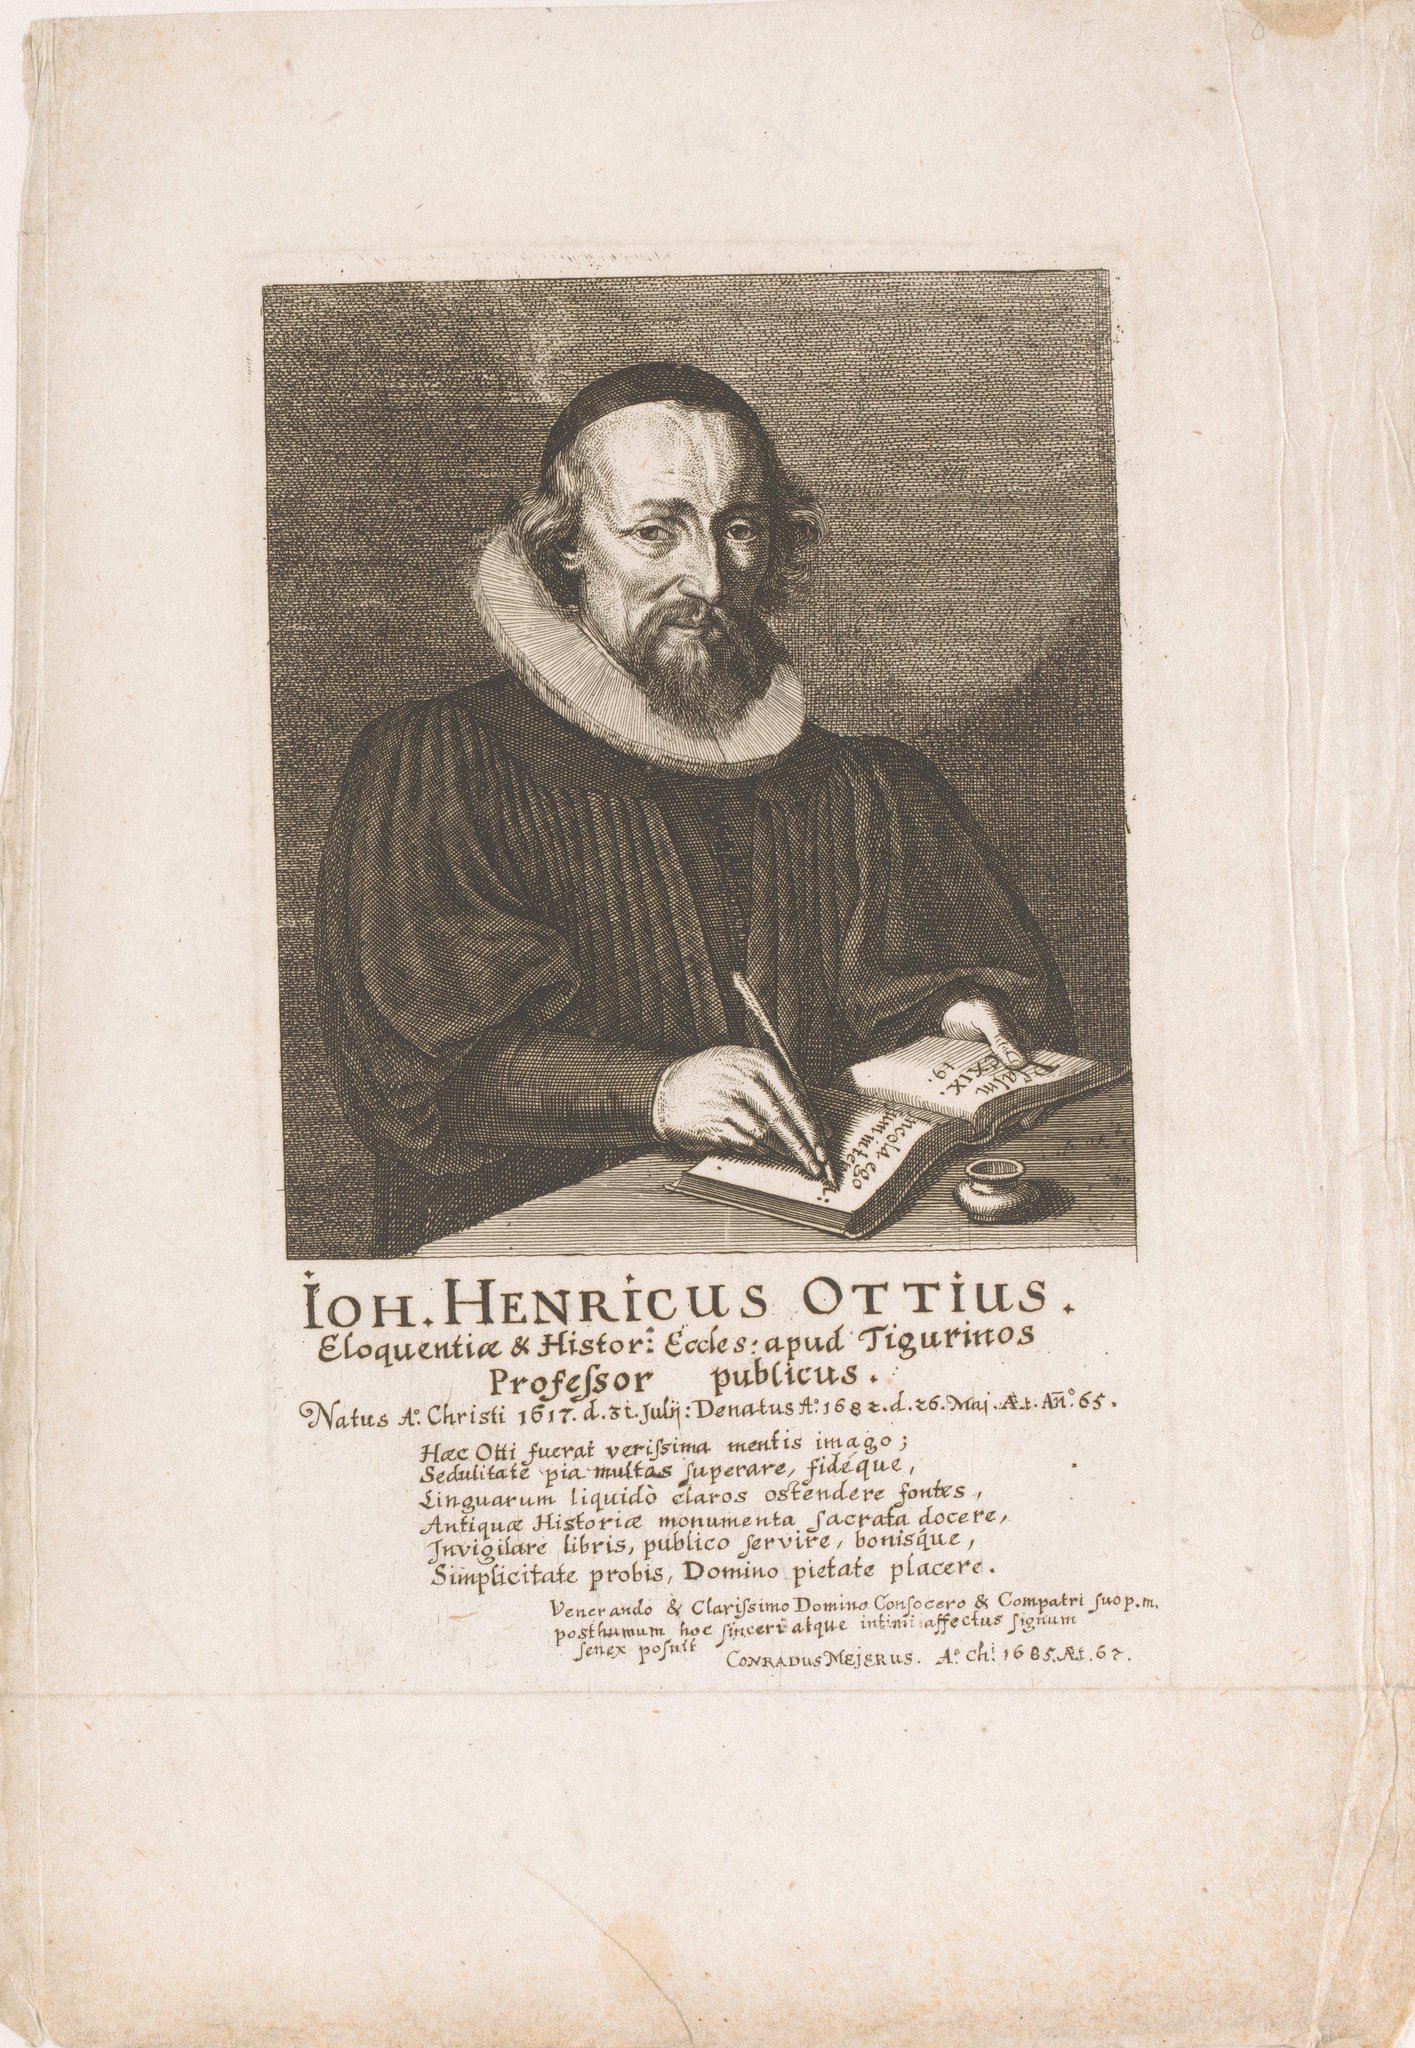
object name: print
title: Portret van Johann Heinrich Ott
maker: conrad meyer (i)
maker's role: painter, print maker, publisher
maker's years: 1618-1689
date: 1685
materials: paper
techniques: engraving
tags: theologian, historical persons, writing accessories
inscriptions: collector's mark: Lugt 2228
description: Onderdeel van een serie van 62 portretten van priesters en theologen van Zürich. Zie Hollstein German 111, 1-41.